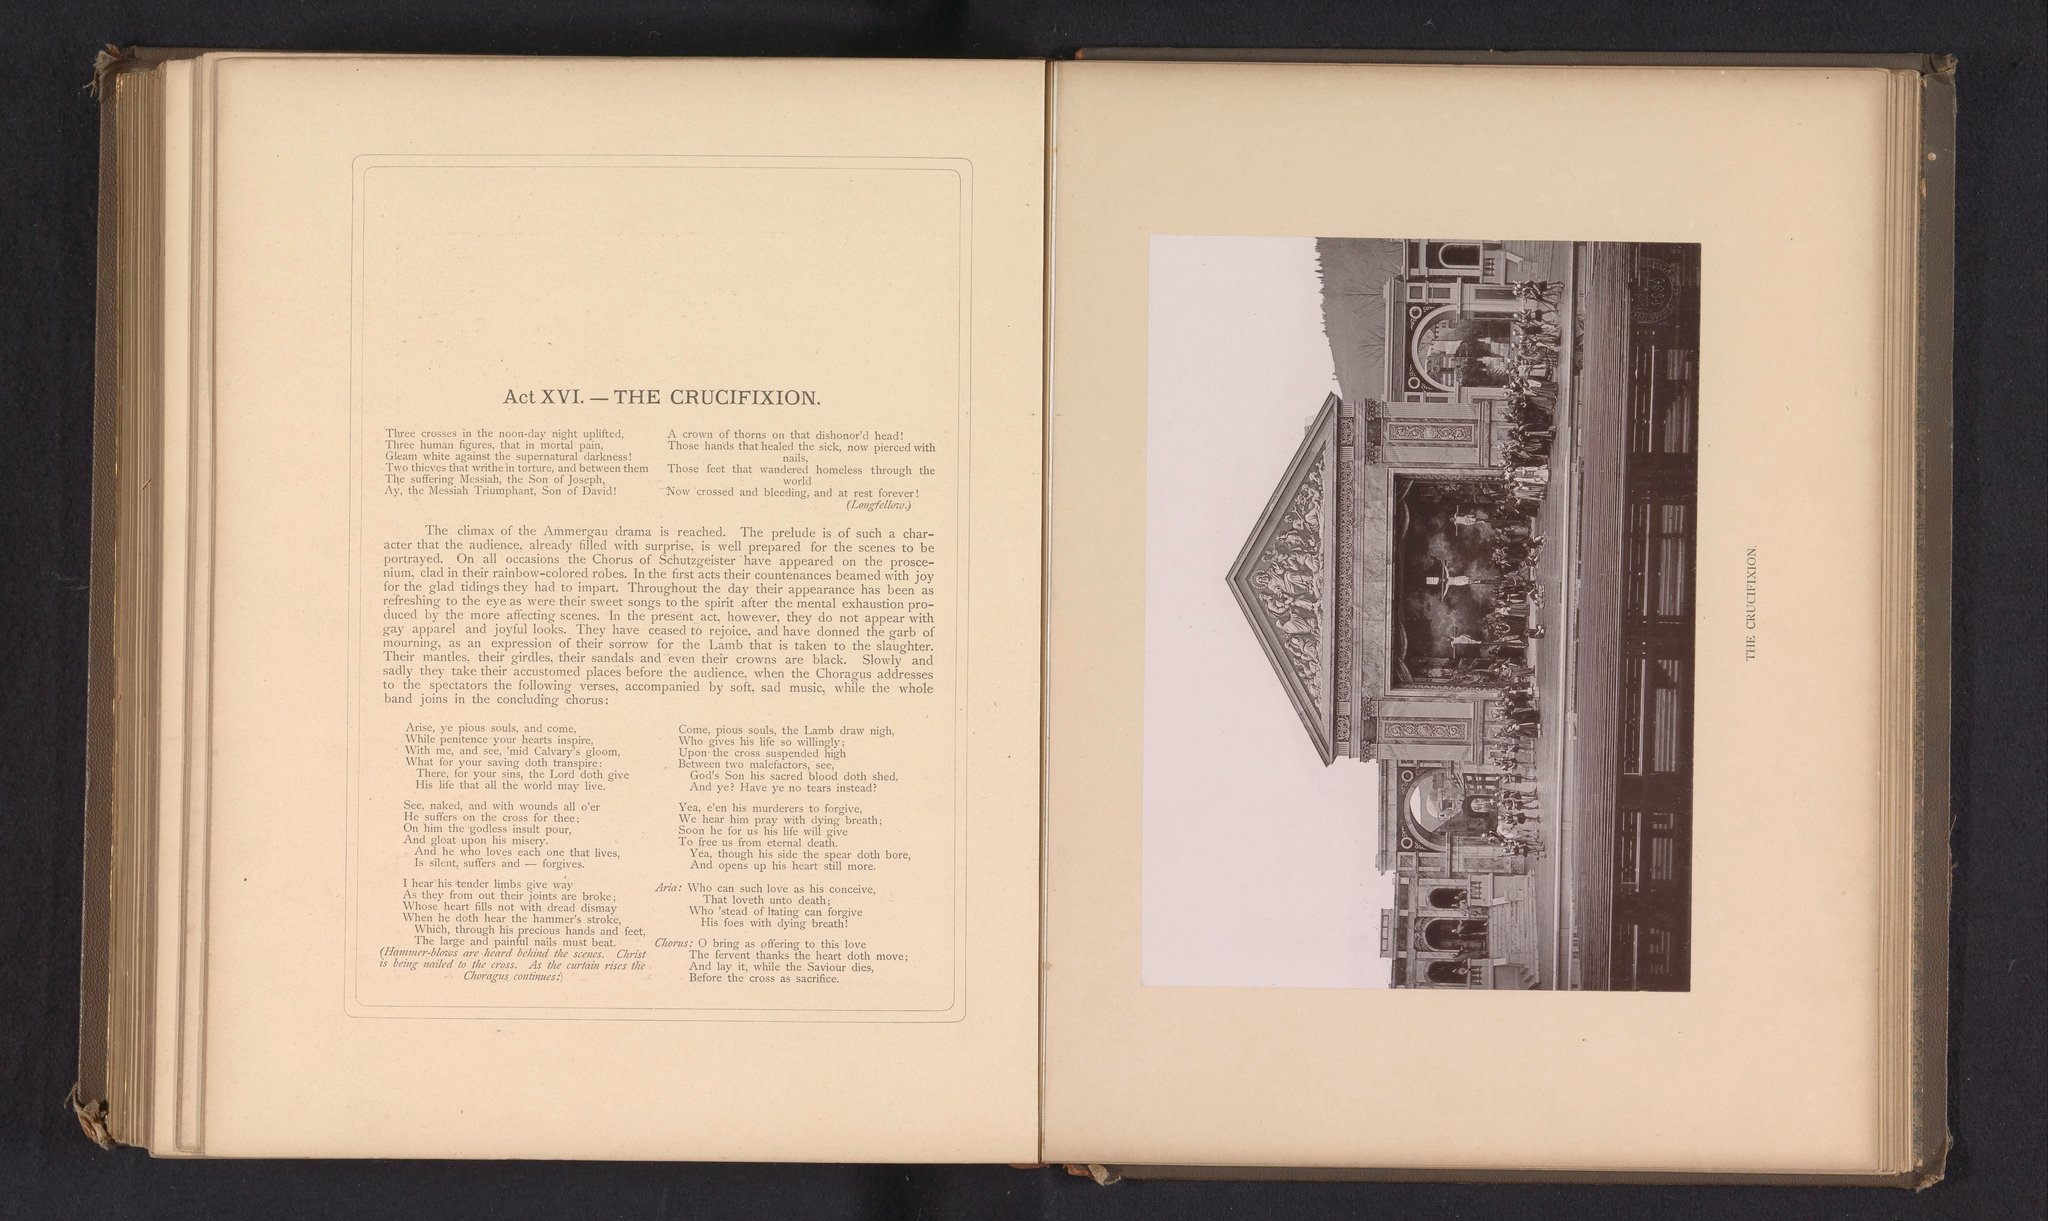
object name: photomechanical print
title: The crucifixion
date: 1885-1890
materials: paper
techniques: photograph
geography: oberammergau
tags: group of actors, troupe; actors on the stage, the crucifixion of christ: christ's death on the cross; golgotha (matthew 27:45-58; mark 15:33-45; luke 23:44-52; john 19:25-38)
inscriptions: inscription: ‘Gemeinde Oberammergau Passionsspiel 1890’